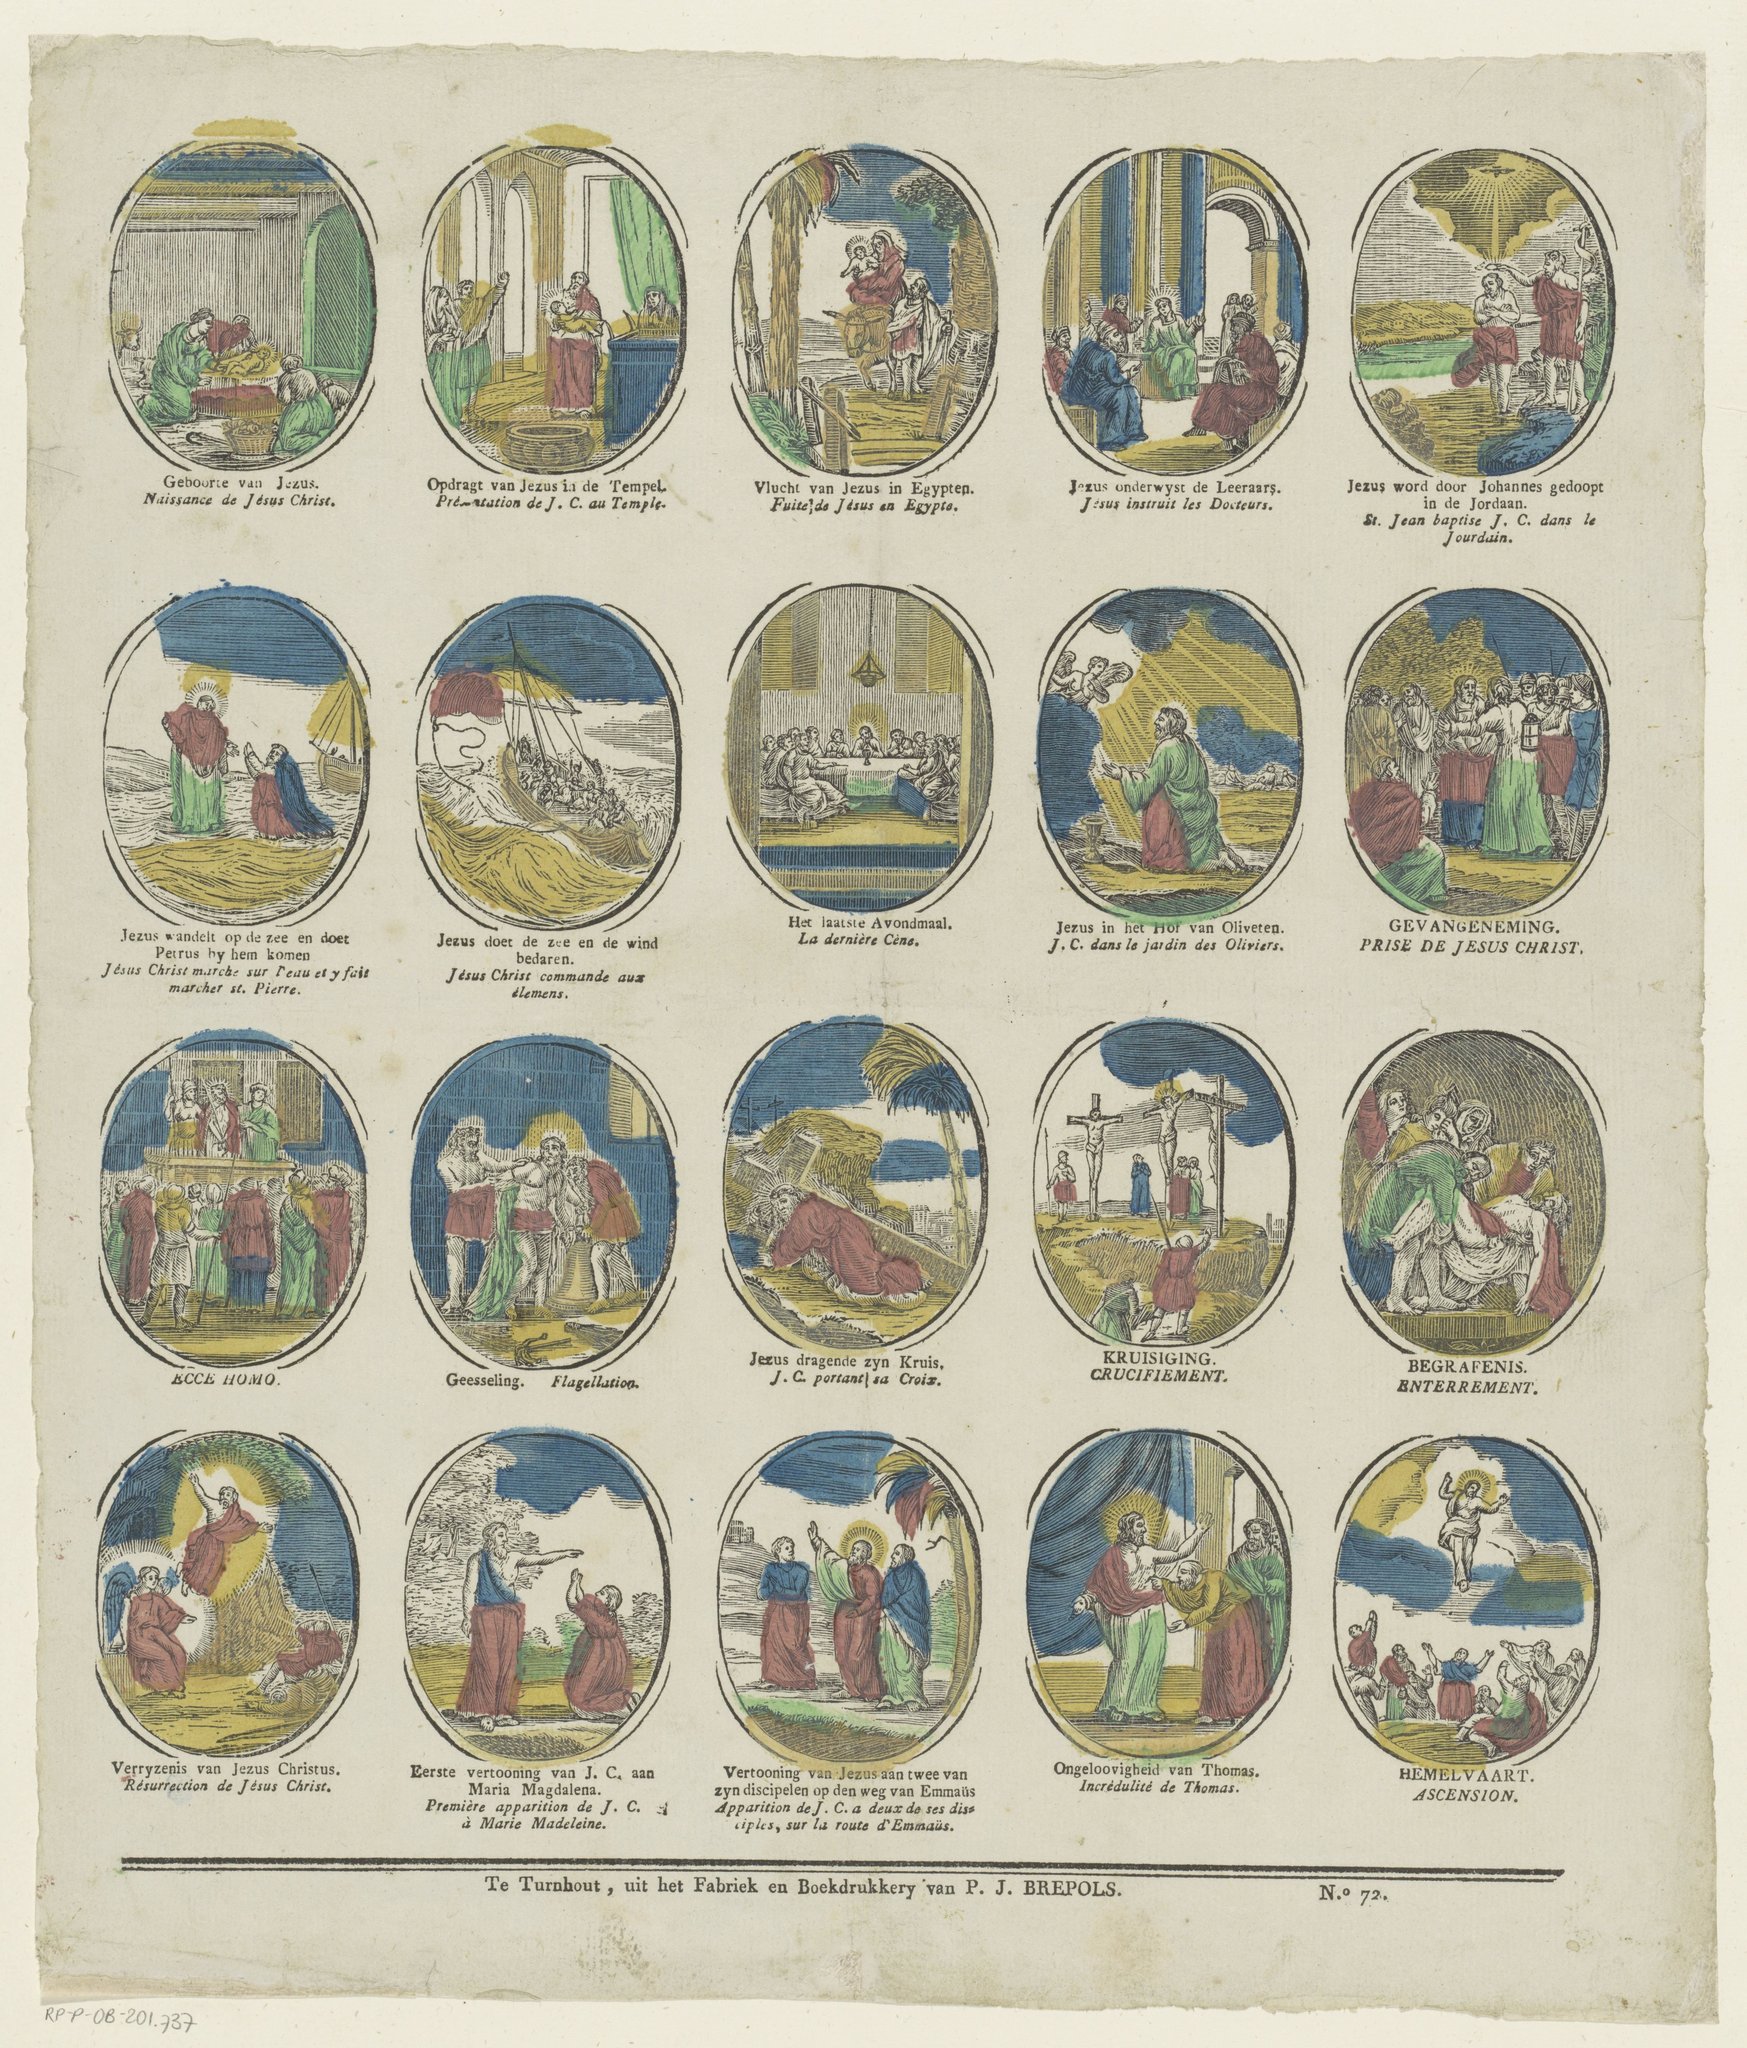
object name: print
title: Bidprentjes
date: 1800-1833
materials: paper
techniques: colour, letterpress printing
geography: turnhout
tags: series of scenes from the life of christ, passion of christ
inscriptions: collector's mark: Lugt 2760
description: Blad met 20 ovale bidprentjes met voorstellingen uit het leven van Christus, waaronder de geboorte van Christus, het Laatste Avondmaal en de hemelvaart van Christus. Onder elke afbeelding een onderschrift in het Nederlands en in het Frans. Genummerd rechtsonder: No. 72.